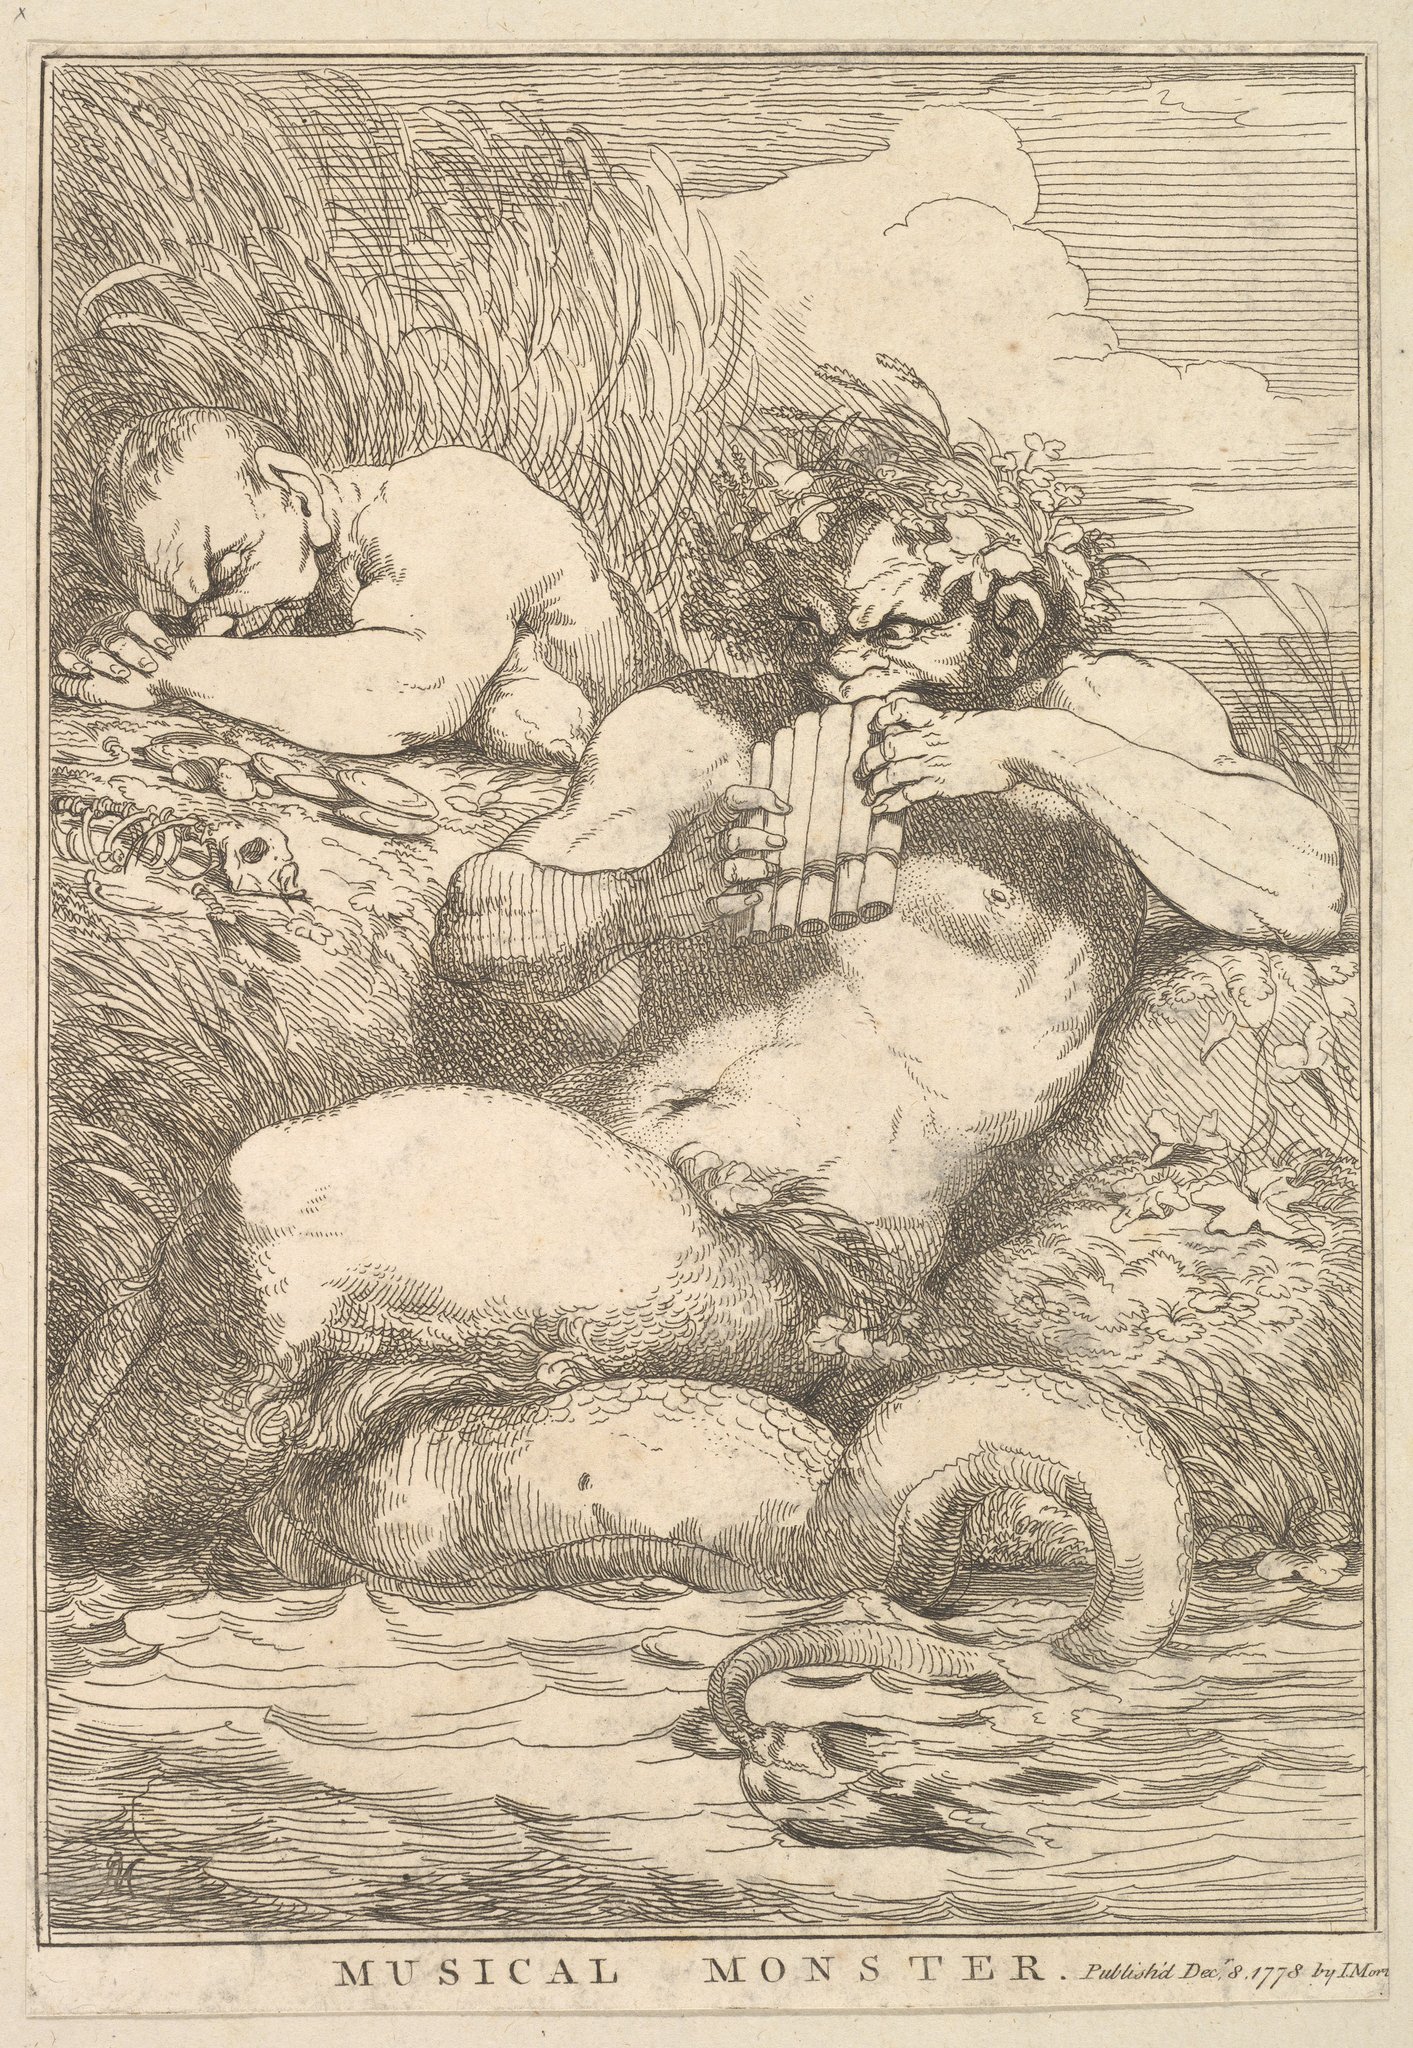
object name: print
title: Musical Monster, from "Fifteen Etchings Dedicated to Sir Joshua Reynolds"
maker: john hamilton mortimer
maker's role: artist and publisher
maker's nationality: british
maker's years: 1740-1779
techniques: etching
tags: musical instruments,monsters